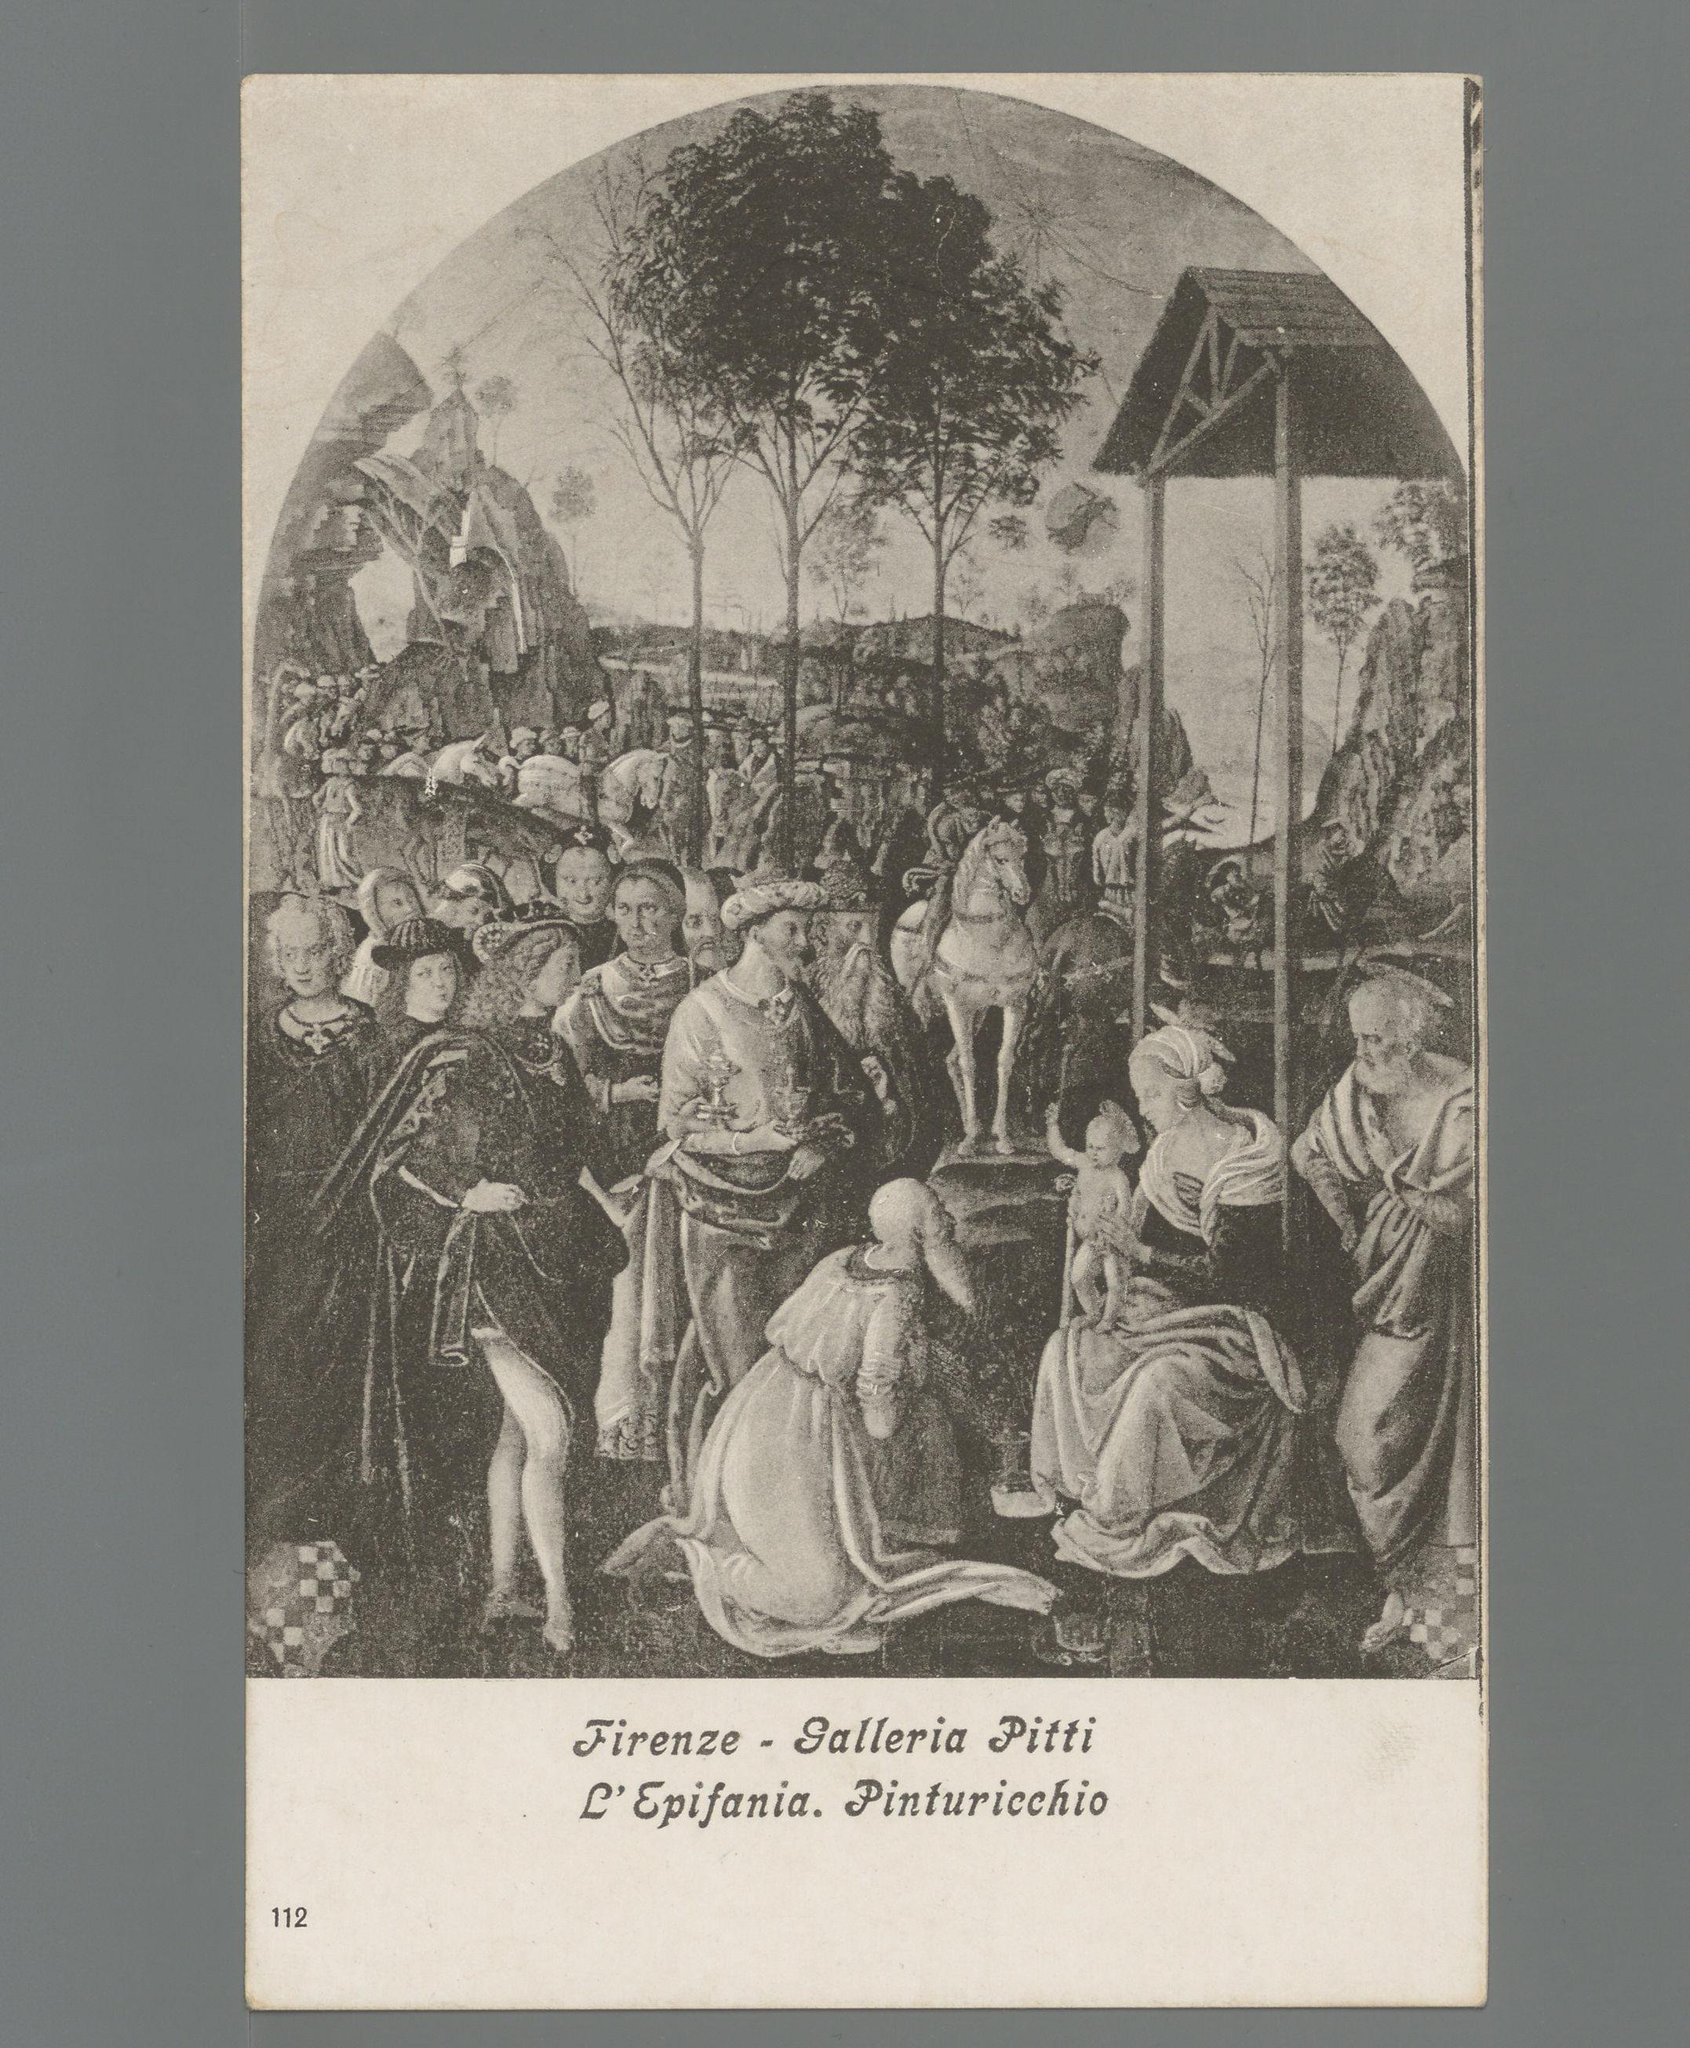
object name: reproduction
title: Firenze - Galleria Pitti. L'Epifania. Pinturicchio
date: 1906-1930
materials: cardboard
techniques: photograph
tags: permanent exhibition, museum, picture, painting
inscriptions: monogram, collector's mark: ‘AFE v S’